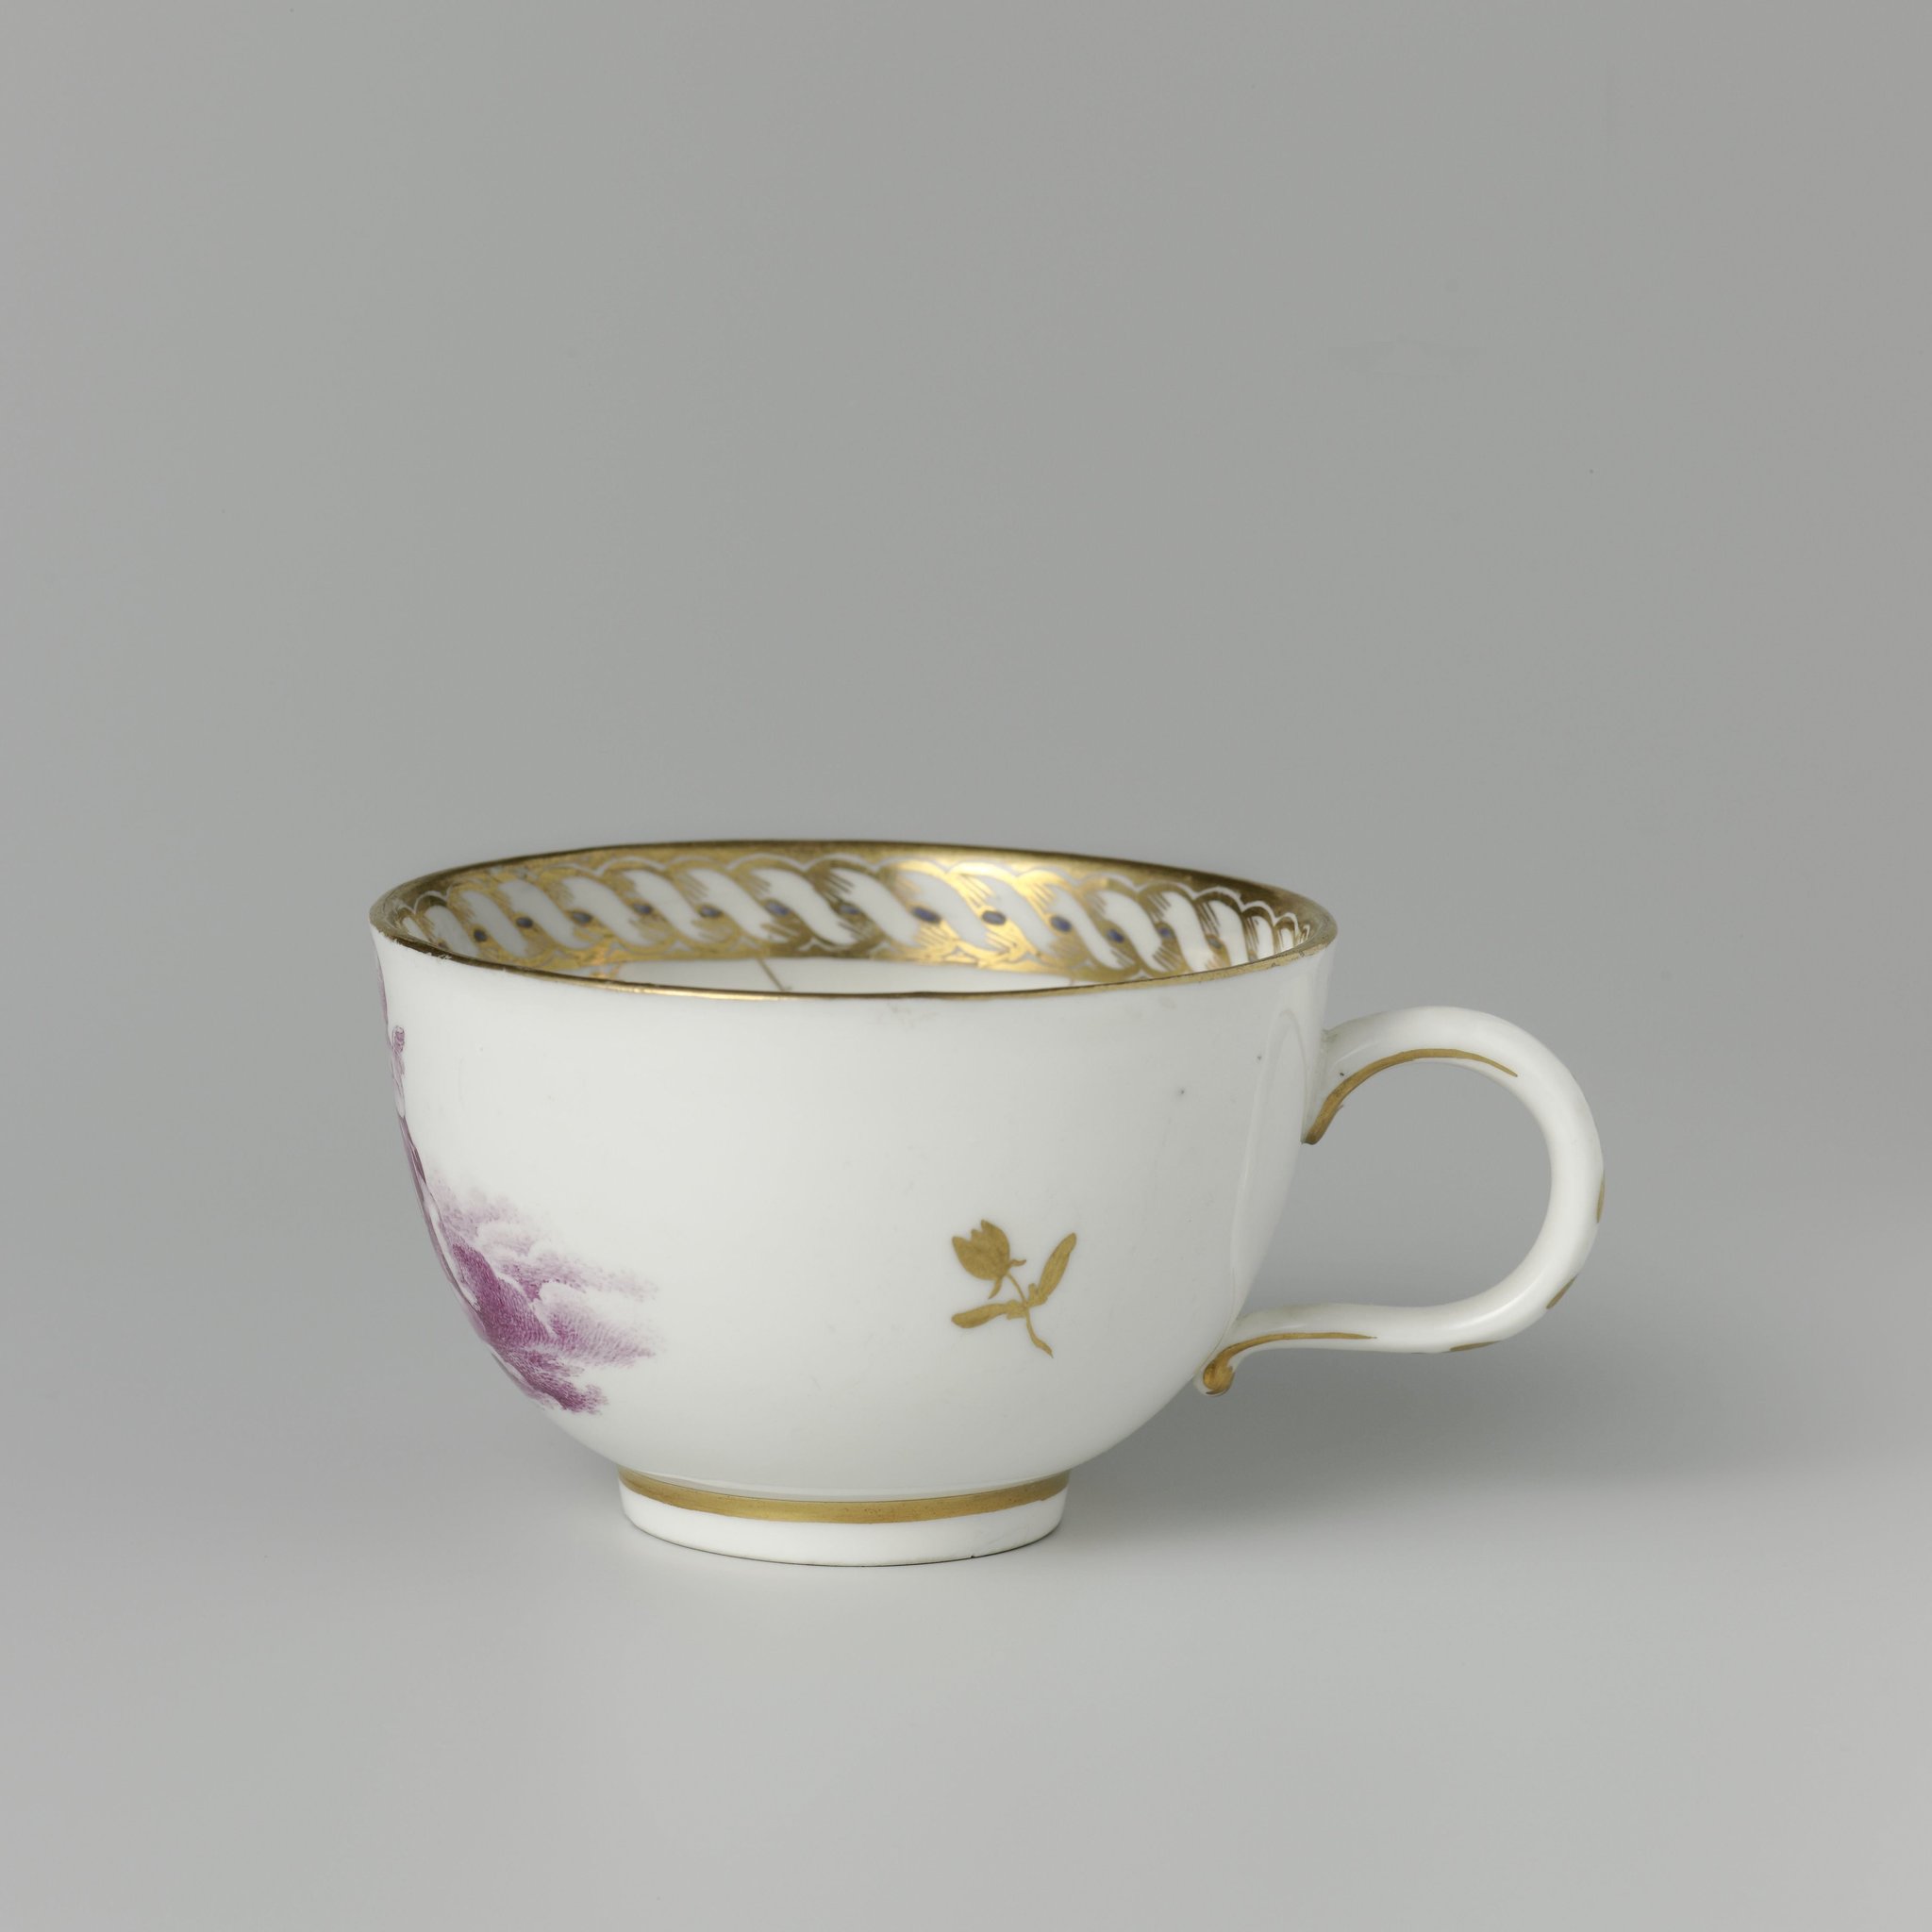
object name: service set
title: Cup with putti on clouds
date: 1785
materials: glaze, gold, paint, porcelain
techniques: firing, forming, gilding, turning, vitrification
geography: the hague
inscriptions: mark: ‘ooievaar’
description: Kop (theekop) van porselein met een C-vormig oor, beschilderd op het glazuur in roze (camaïeu) en goud. Op de buitenwand twee putti op een wolk met een portretmedaillon in hun handen. Het portret is van een man en profil. Om de voorstelling strooibloemen in goud. De binnenrand met een gedraaide band, waaraan guirlandes en bloemtakken hangen. Gouden lijn op de voet en gouden rand. Gemerkt op de onderzijde met de ooievaar.